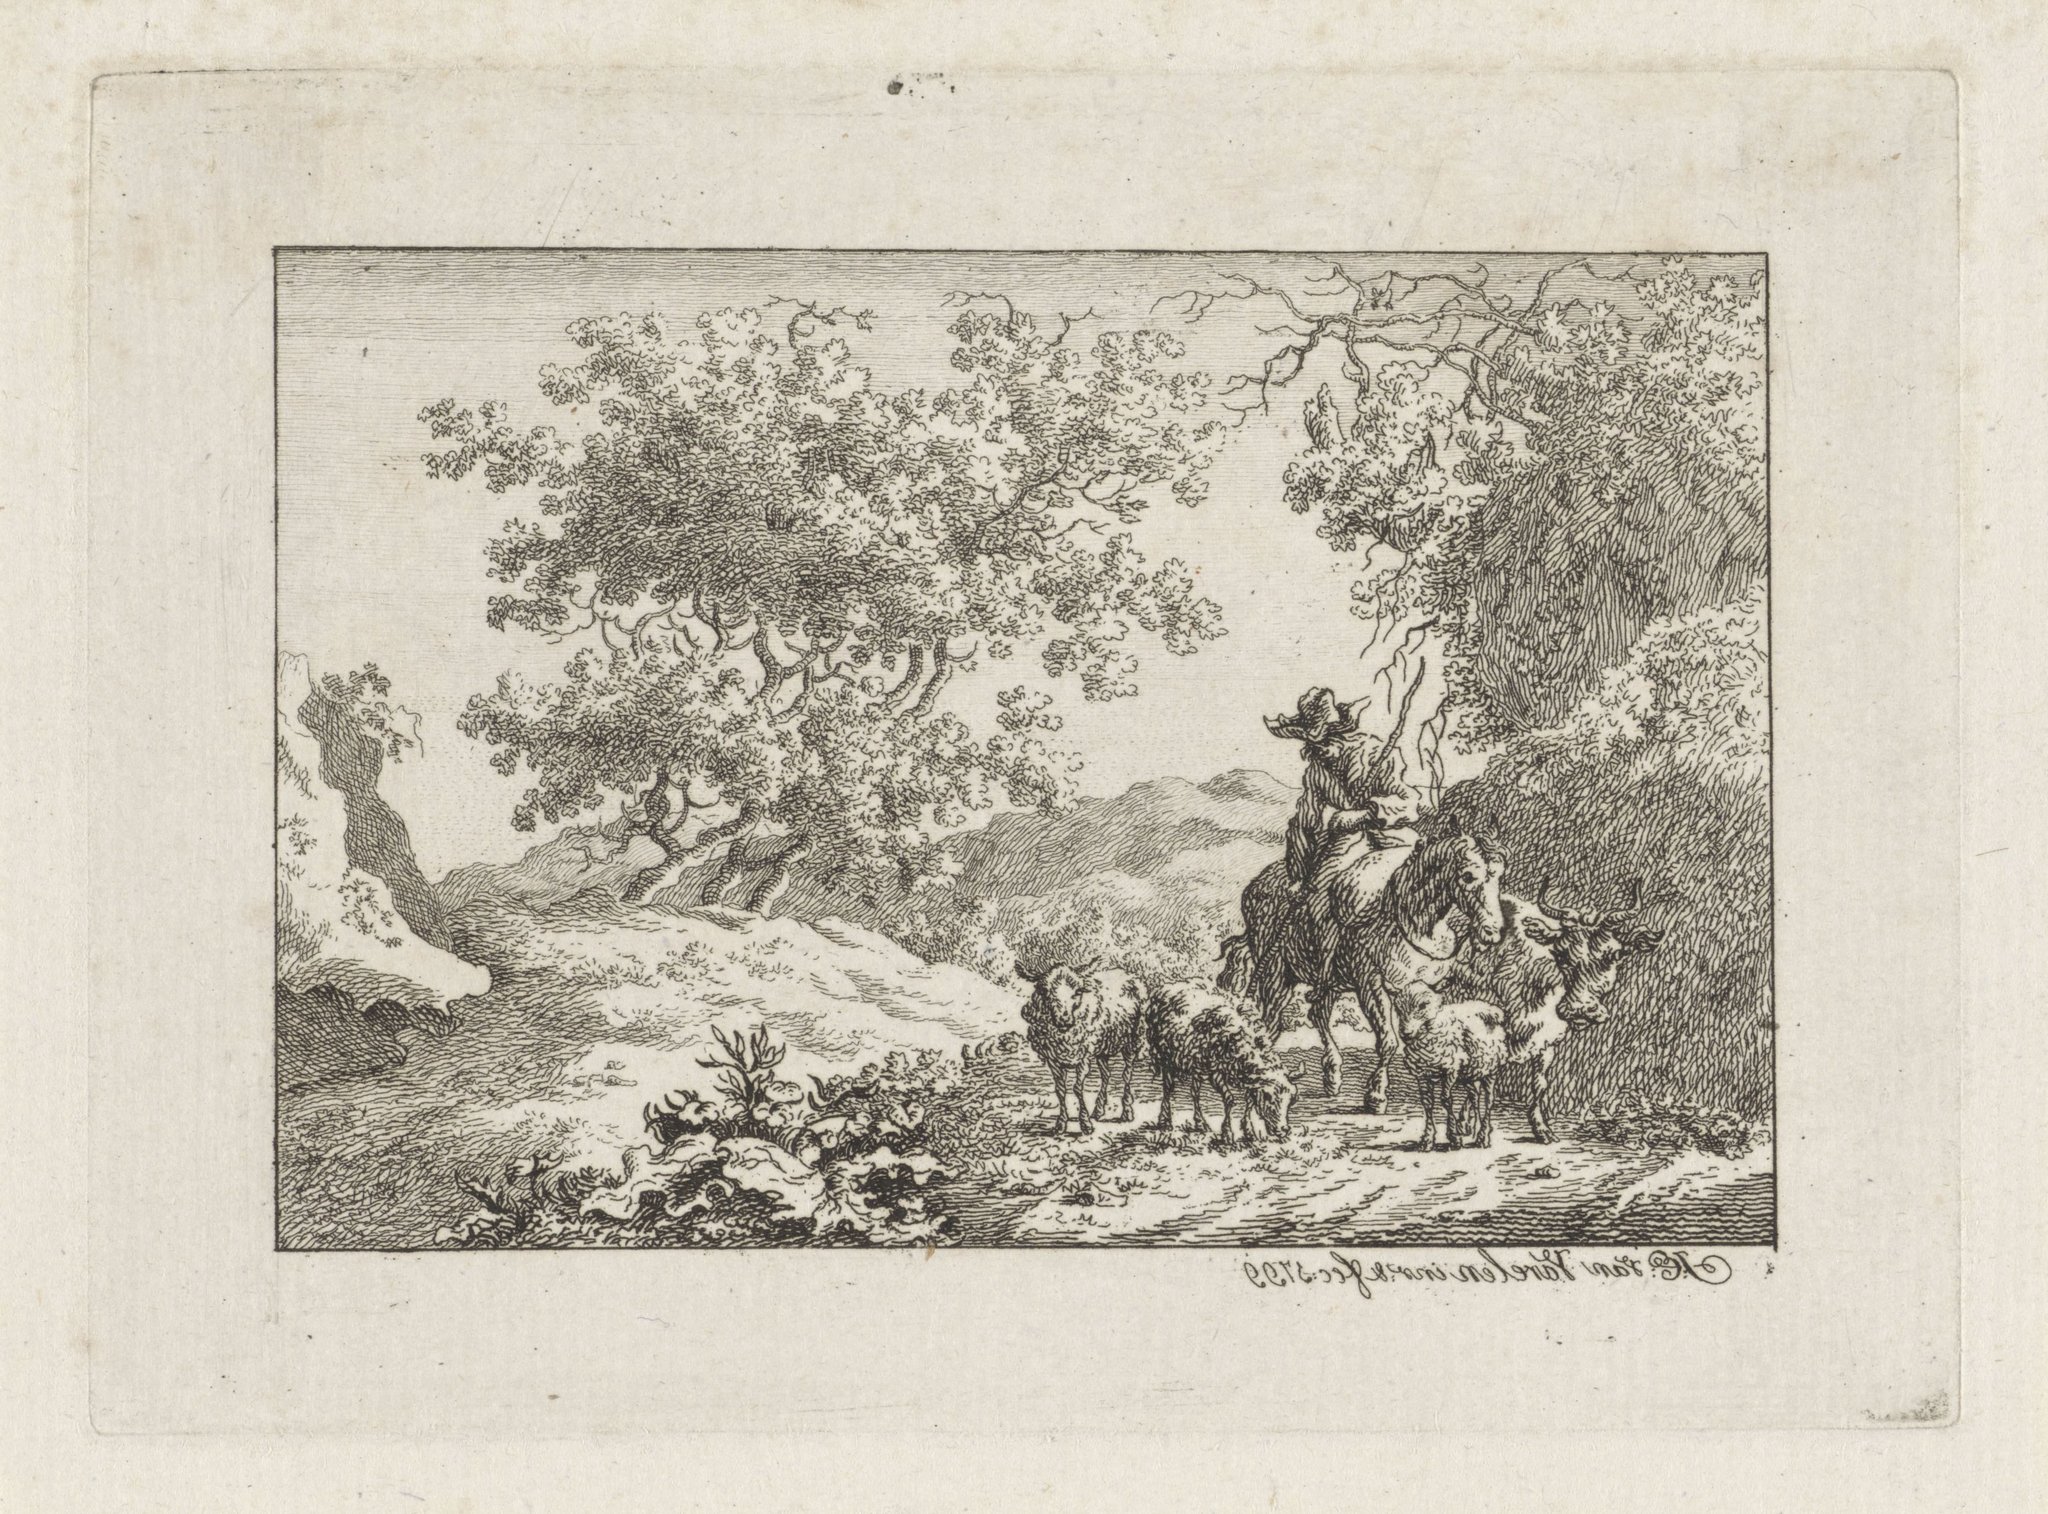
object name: print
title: Herder te paard met kudde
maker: jacob elias van varelen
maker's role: draughtsman, print maker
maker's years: 1757-1840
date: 1799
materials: paper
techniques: etching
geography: haarlem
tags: riding a horse, ass, or mule; rider, horseman, herding, herdsman, herdswoman, shepherd, shepherdess, cowherd, etc., cattle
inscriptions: collector's mark: Lugt 2228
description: Herder te paard met zijn kudde in een heuvelachtig landschap.